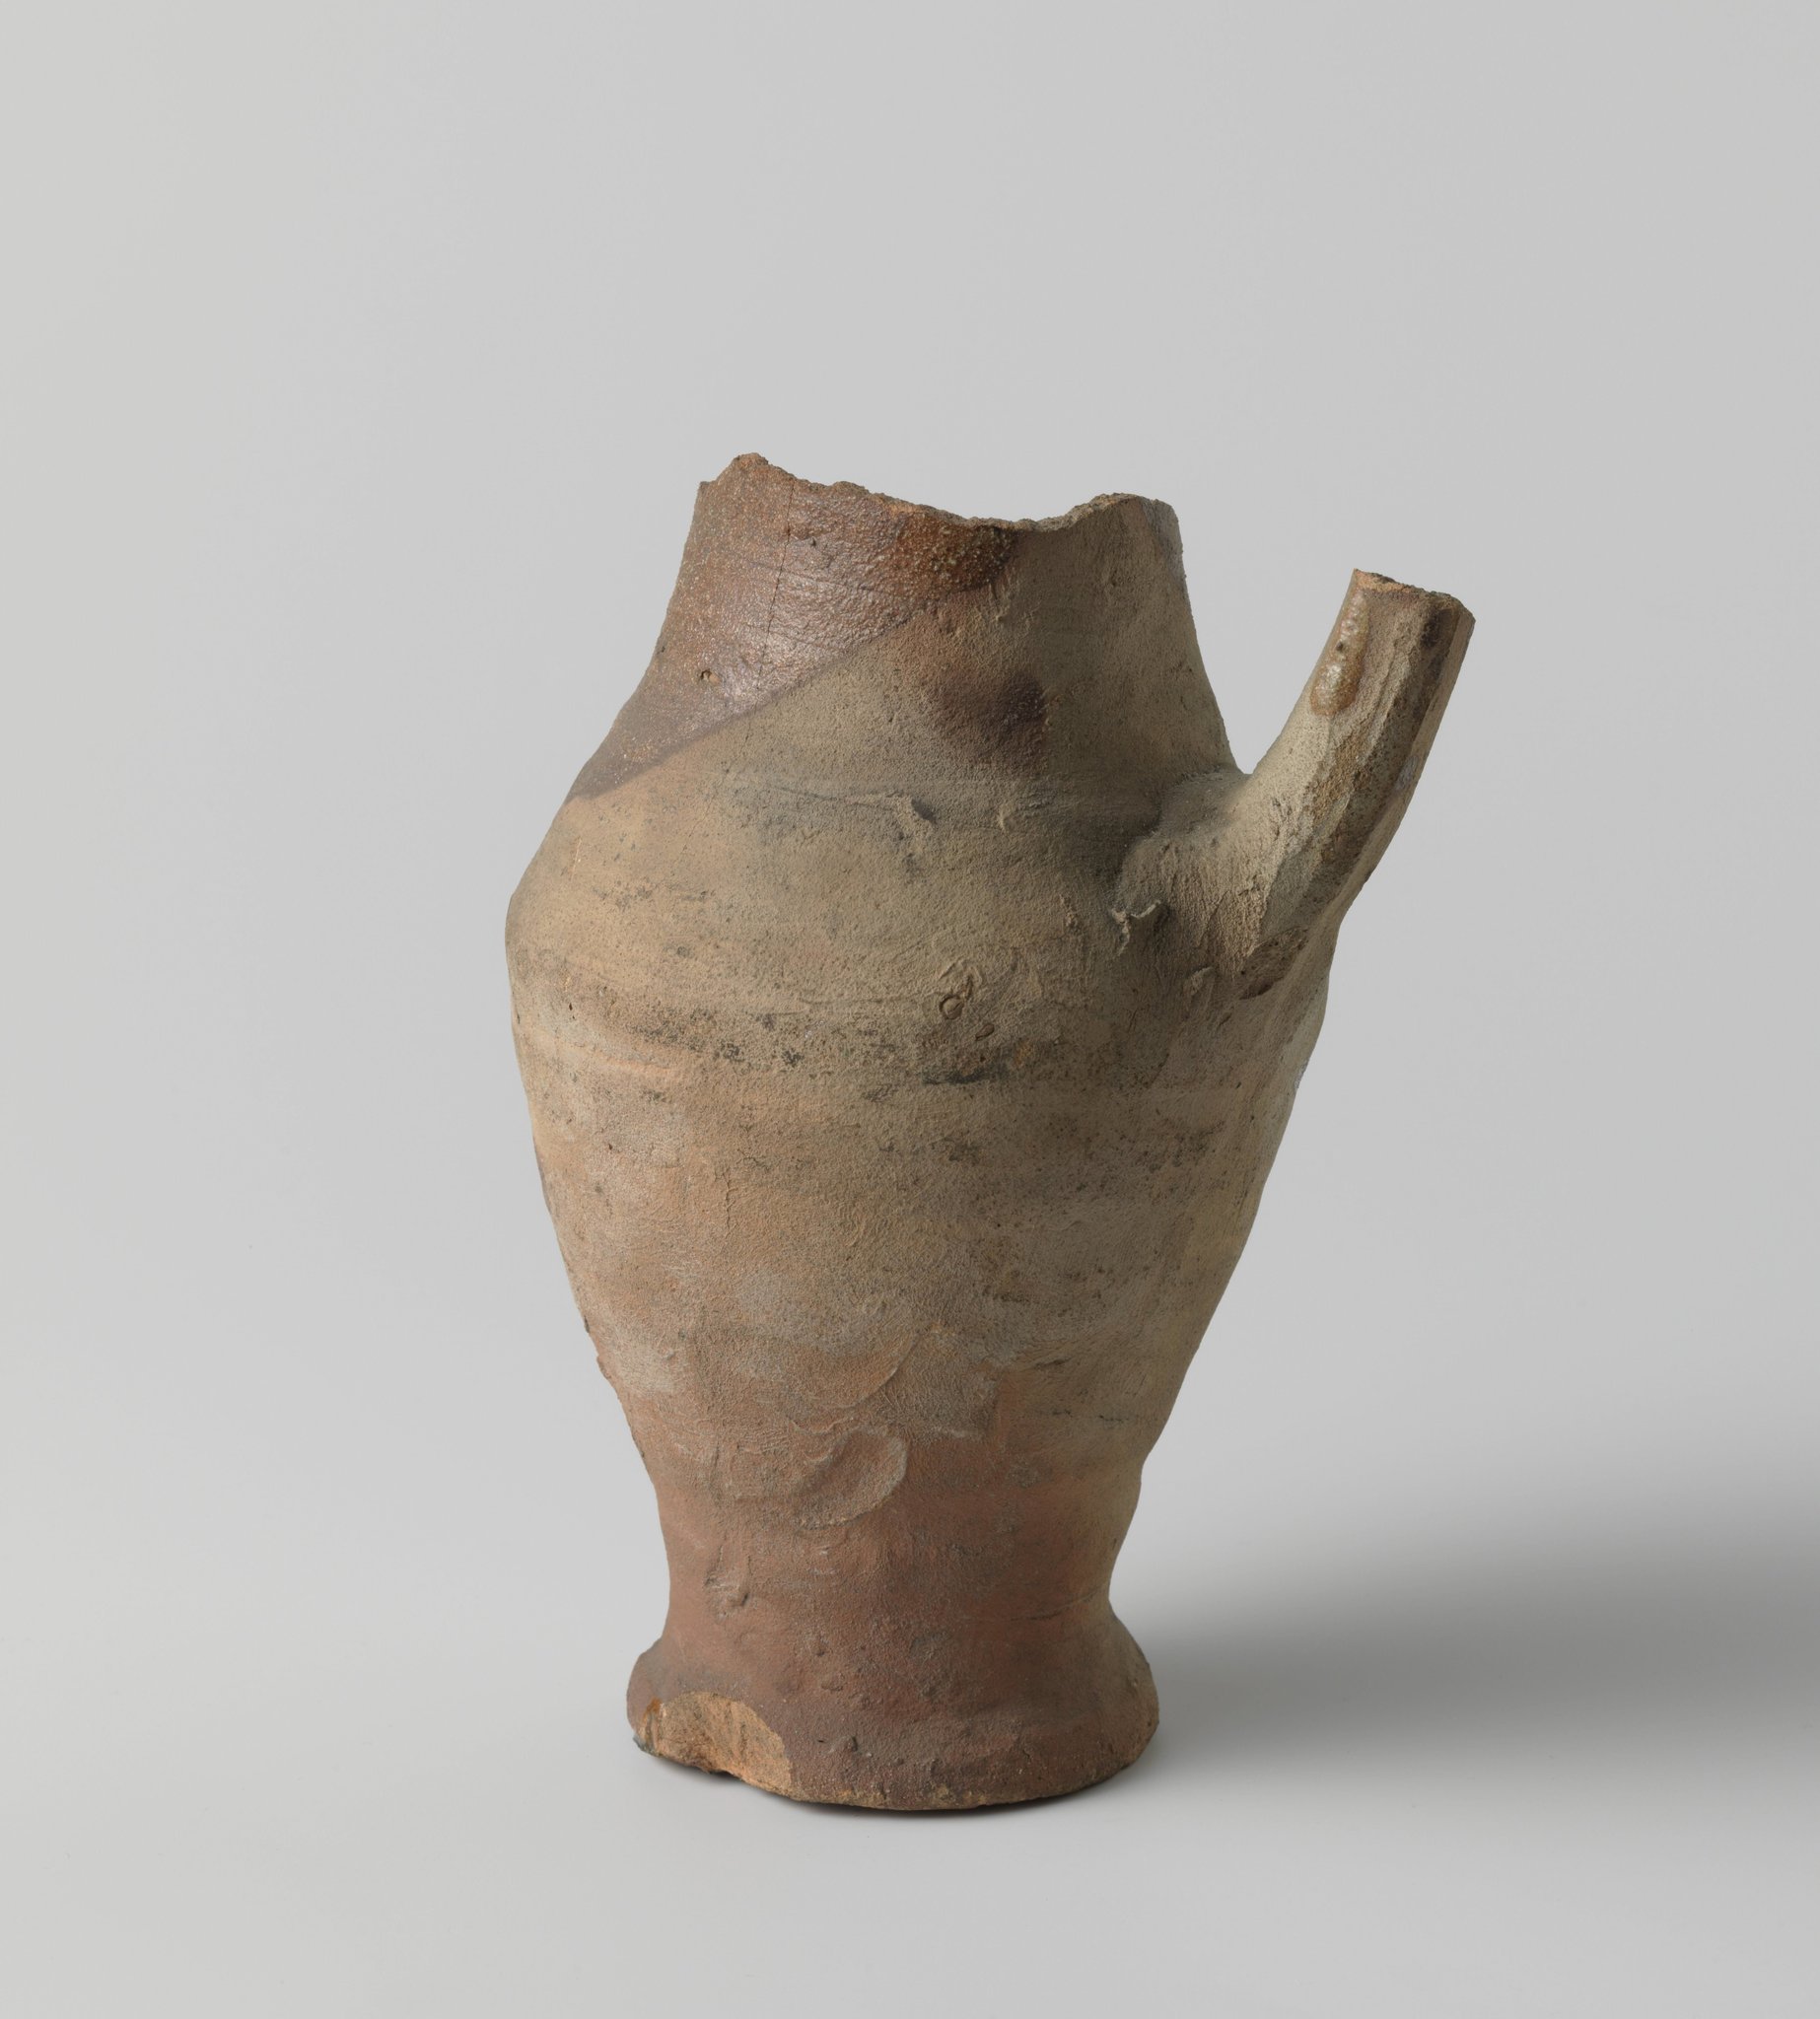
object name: jug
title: Fragment van kruik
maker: Anonymous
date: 1700-1800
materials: earthenware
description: Fragment van een kruik, resten van glazuur op binnen- en buitenkant. Oor en bovenrand afgebroken.